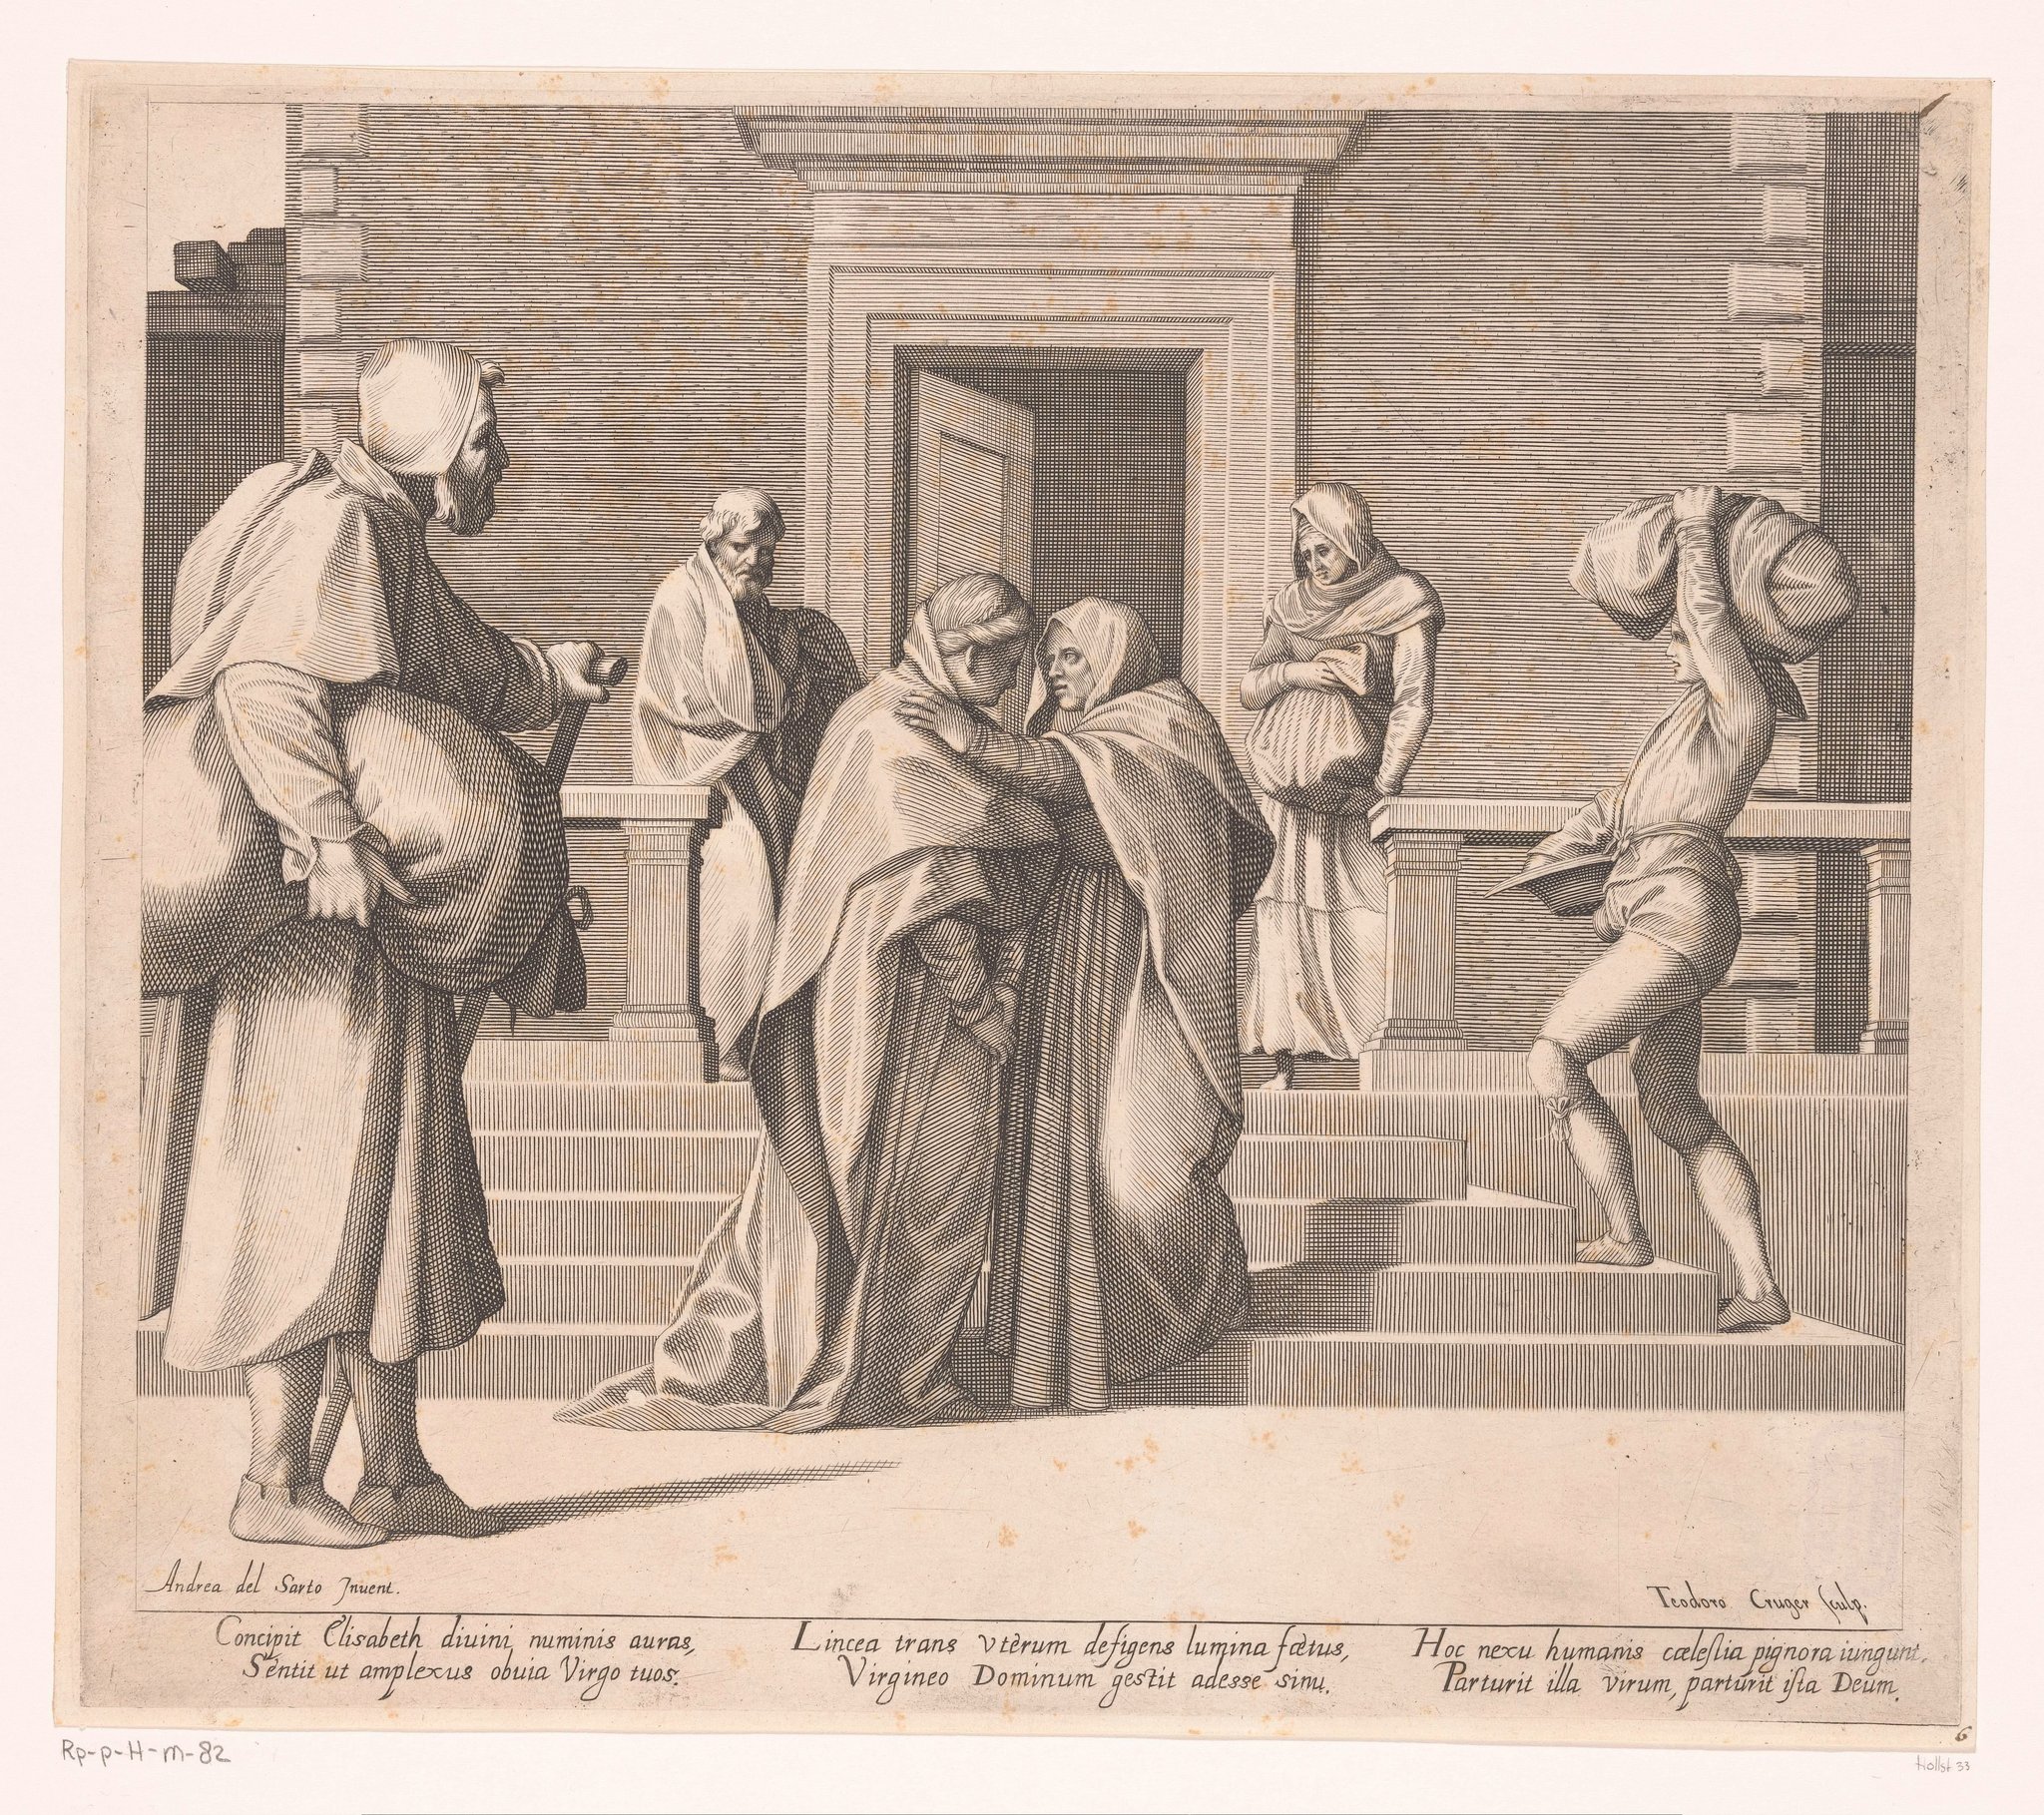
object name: print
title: Vita D. ioannis Baptistae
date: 1617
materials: paper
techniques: engraving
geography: vatican city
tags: mary and elisabeth, both pregnant, embracing, visitation (possibly joseph and/or zacharias present) (luke 1:39-56)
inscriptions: collector's mark: ‘Hinloopen’, collector's mark: Lugt 11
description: Onderdeel van een serie van dertien prenten en een titelprent. Origineel onderdeel geweest van het album Schijnvoet-nummer 24.